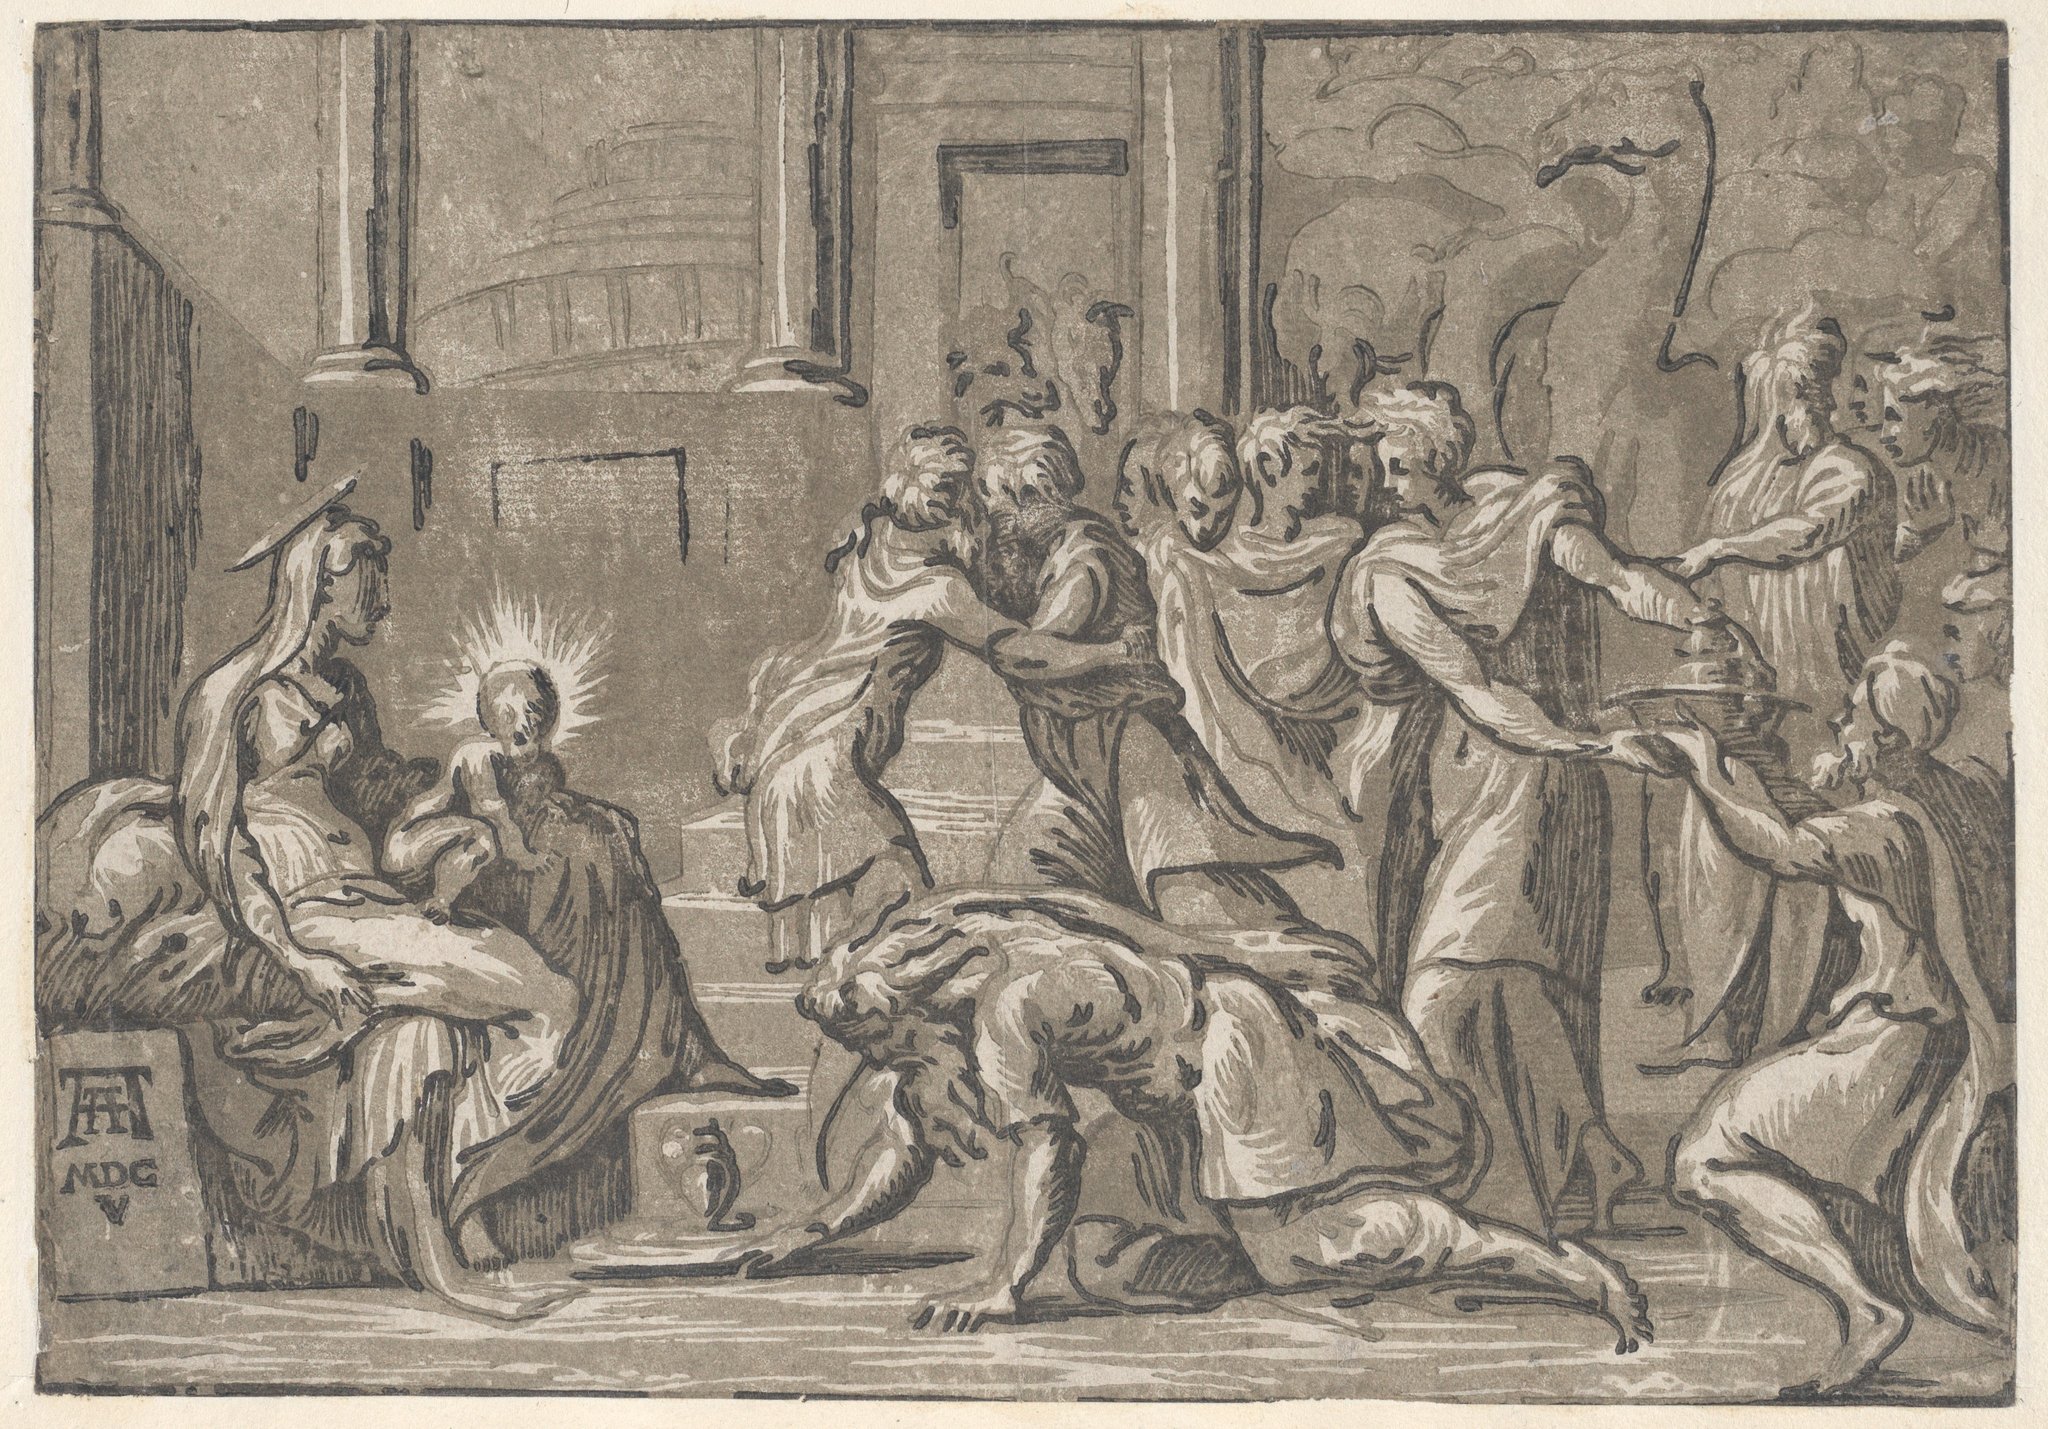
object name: print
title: The Adoration of the Magi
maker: niccolò vicentino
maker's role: artist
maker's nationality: italian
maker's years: 1510-1550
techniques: woodcut